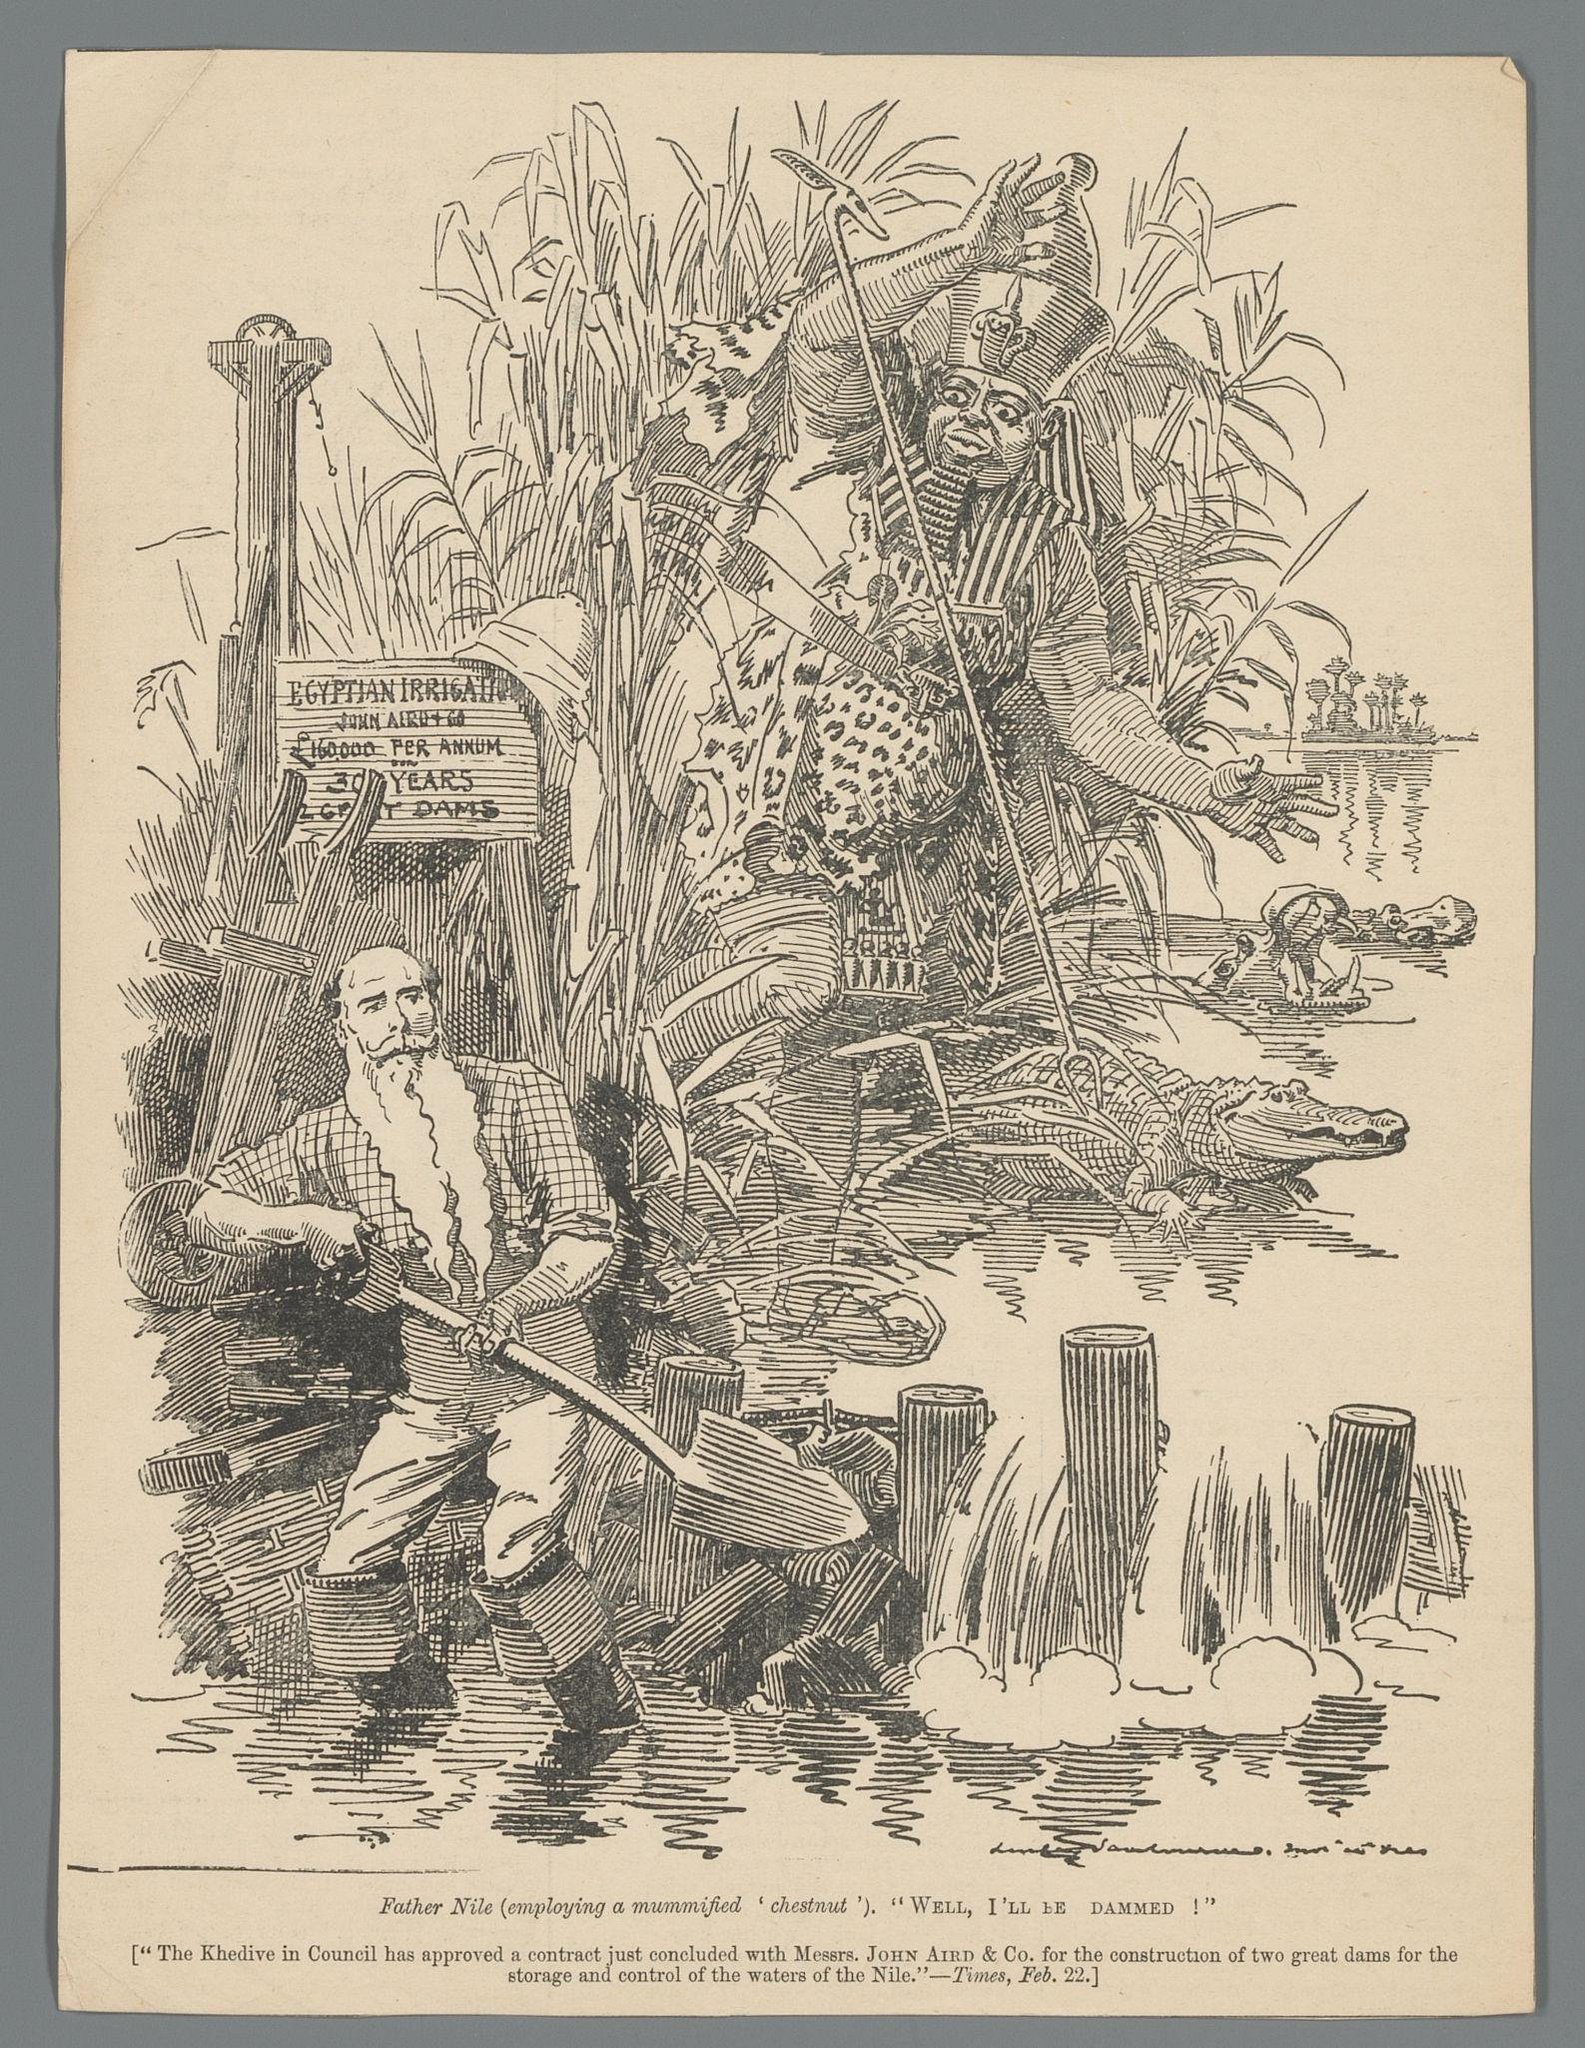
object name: cartoon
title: Dammen in de Nijl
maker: edward linley sambourne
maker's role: draughtsman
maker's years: 1844-1910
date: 1898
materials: paper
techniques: line block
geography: england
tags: building activities, river, barrage, personification of river nile; 'nilo' (ripa), political caricatures and satires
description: Een Engels bedrijf krijgt toestemming om twee stuwdammen in de Nijl te bouwen. De riviergod van de Nijl ziet verschrikt hoe een man met een schep een dammetje opwerpt in het water. Spotprent in het Engelse satirische tijdschrift Punch, 1898.